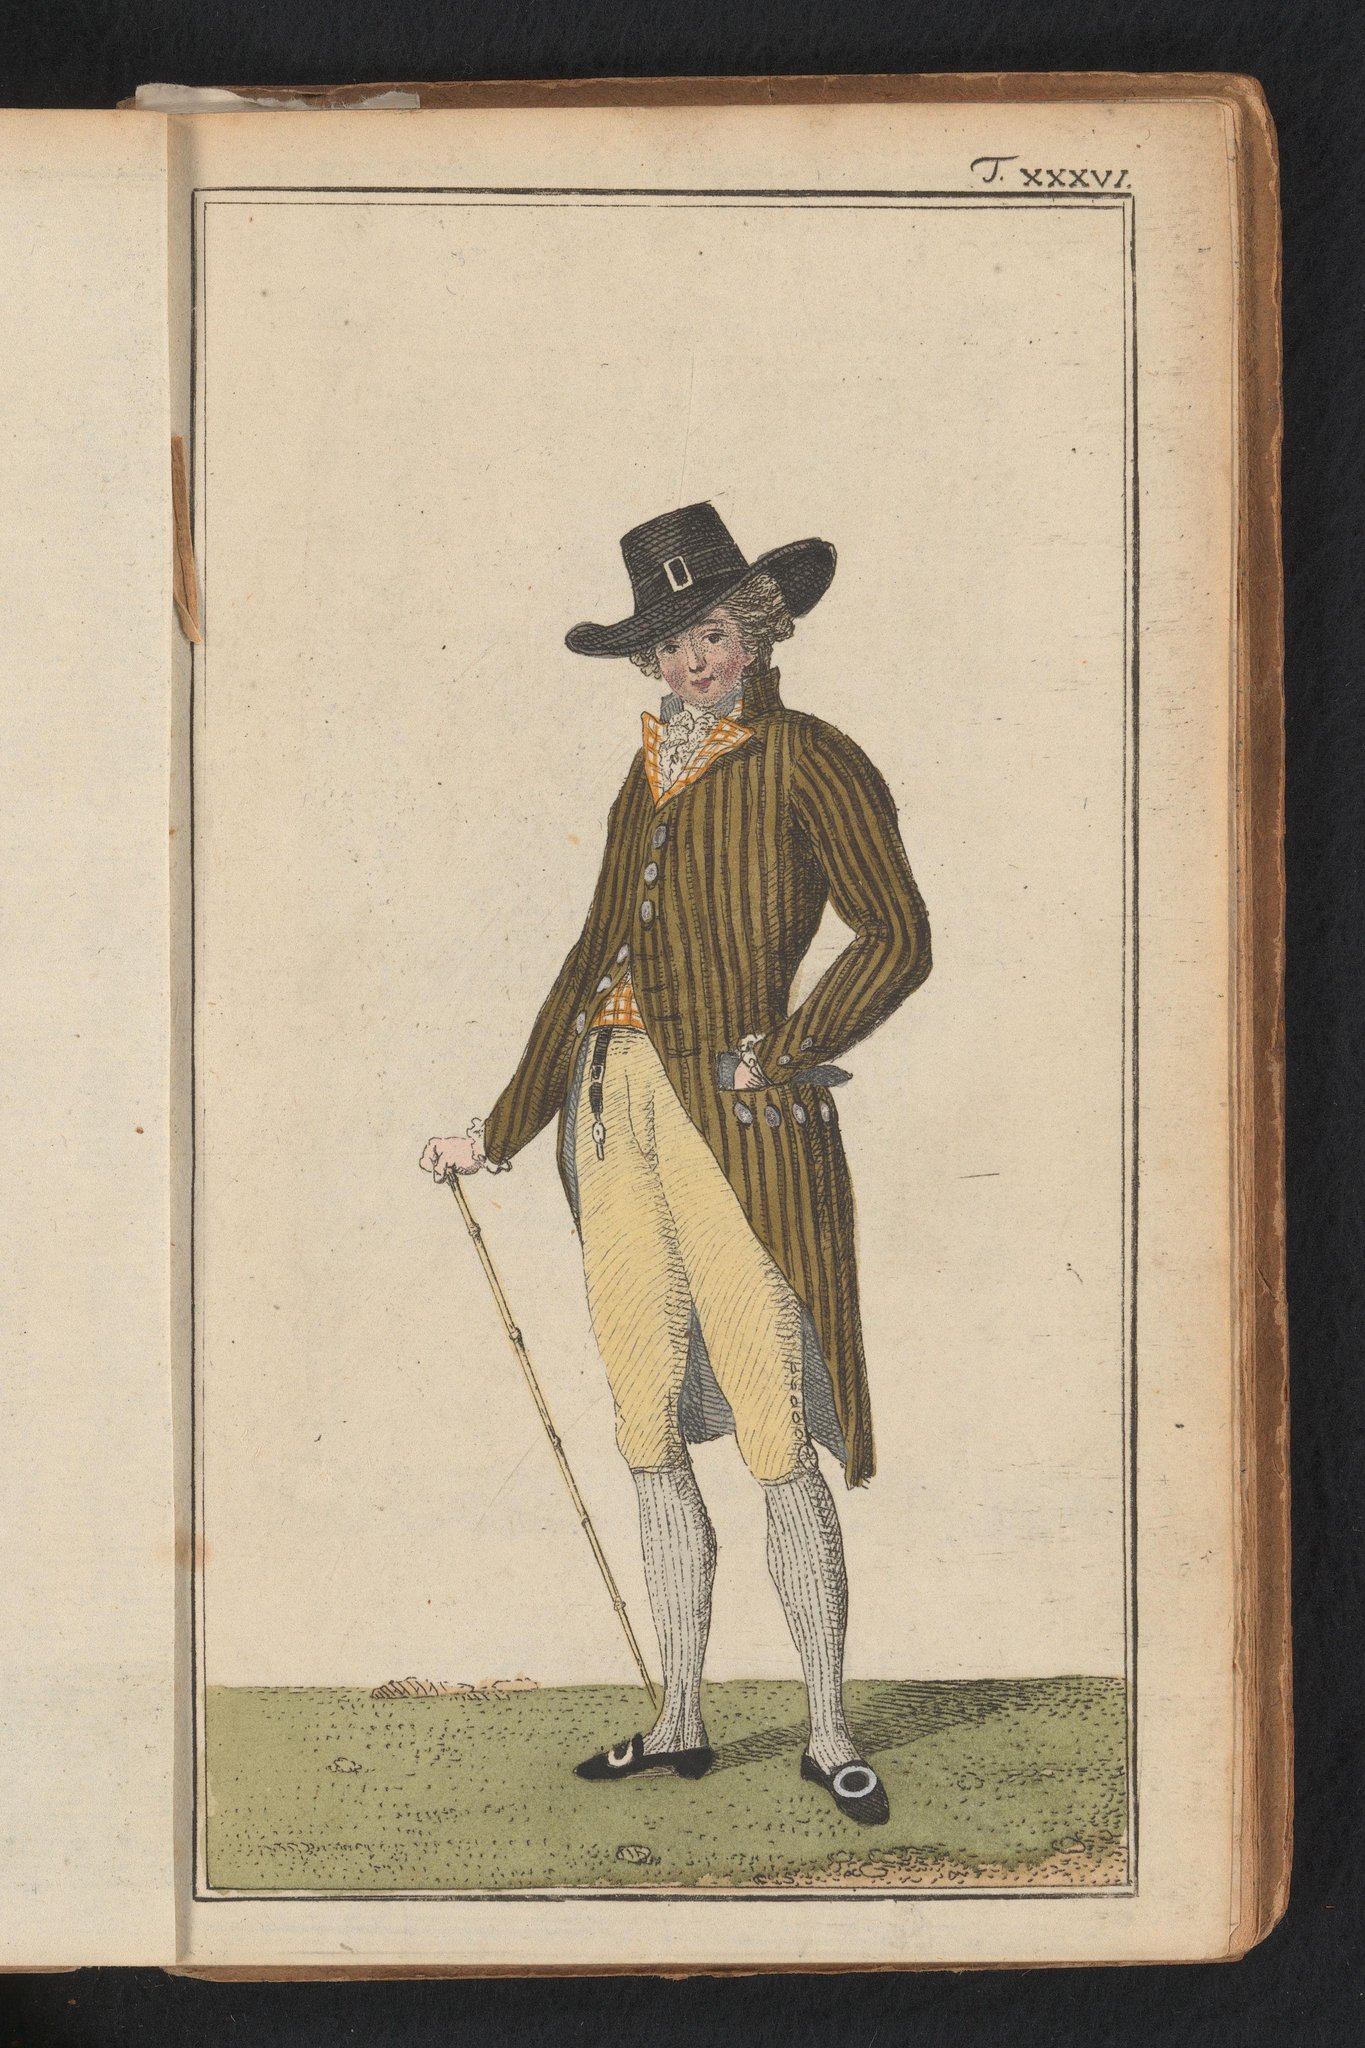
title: Journal des Luxus und der Moden 1786, Band I, T. 36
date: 1786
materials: paper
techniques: etching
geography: weimar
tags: fashion plates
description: Engelse heer, naar de laatste mode gekleed. Volgens de begeleidende tekst gekopieerd naar een Londens model, om aan te tonen dat men ook in Engeland (net als in Frankrijk en Duitsland) de mode overdrijft. De jongeman draagt een jockeyhoed met hoedenband en gesp op het gefriseerde kapsel. Hij is gekleed in een gestreepte frak met hoge kraag en zilveren knopen over een gilet en kuitbroek van Kasimir (kasjmier ??). Gestreepte kousen; schoenen met grote ovale gespen. Horloge aan breloque. Wandelstok in de hand. Prent uit het modetijdschrift Journal des Luxus und der Moden, uitgegeven door Friedrich Justin Bertuch en Georg Melchior Kraus, Weimar, 1786-1826.